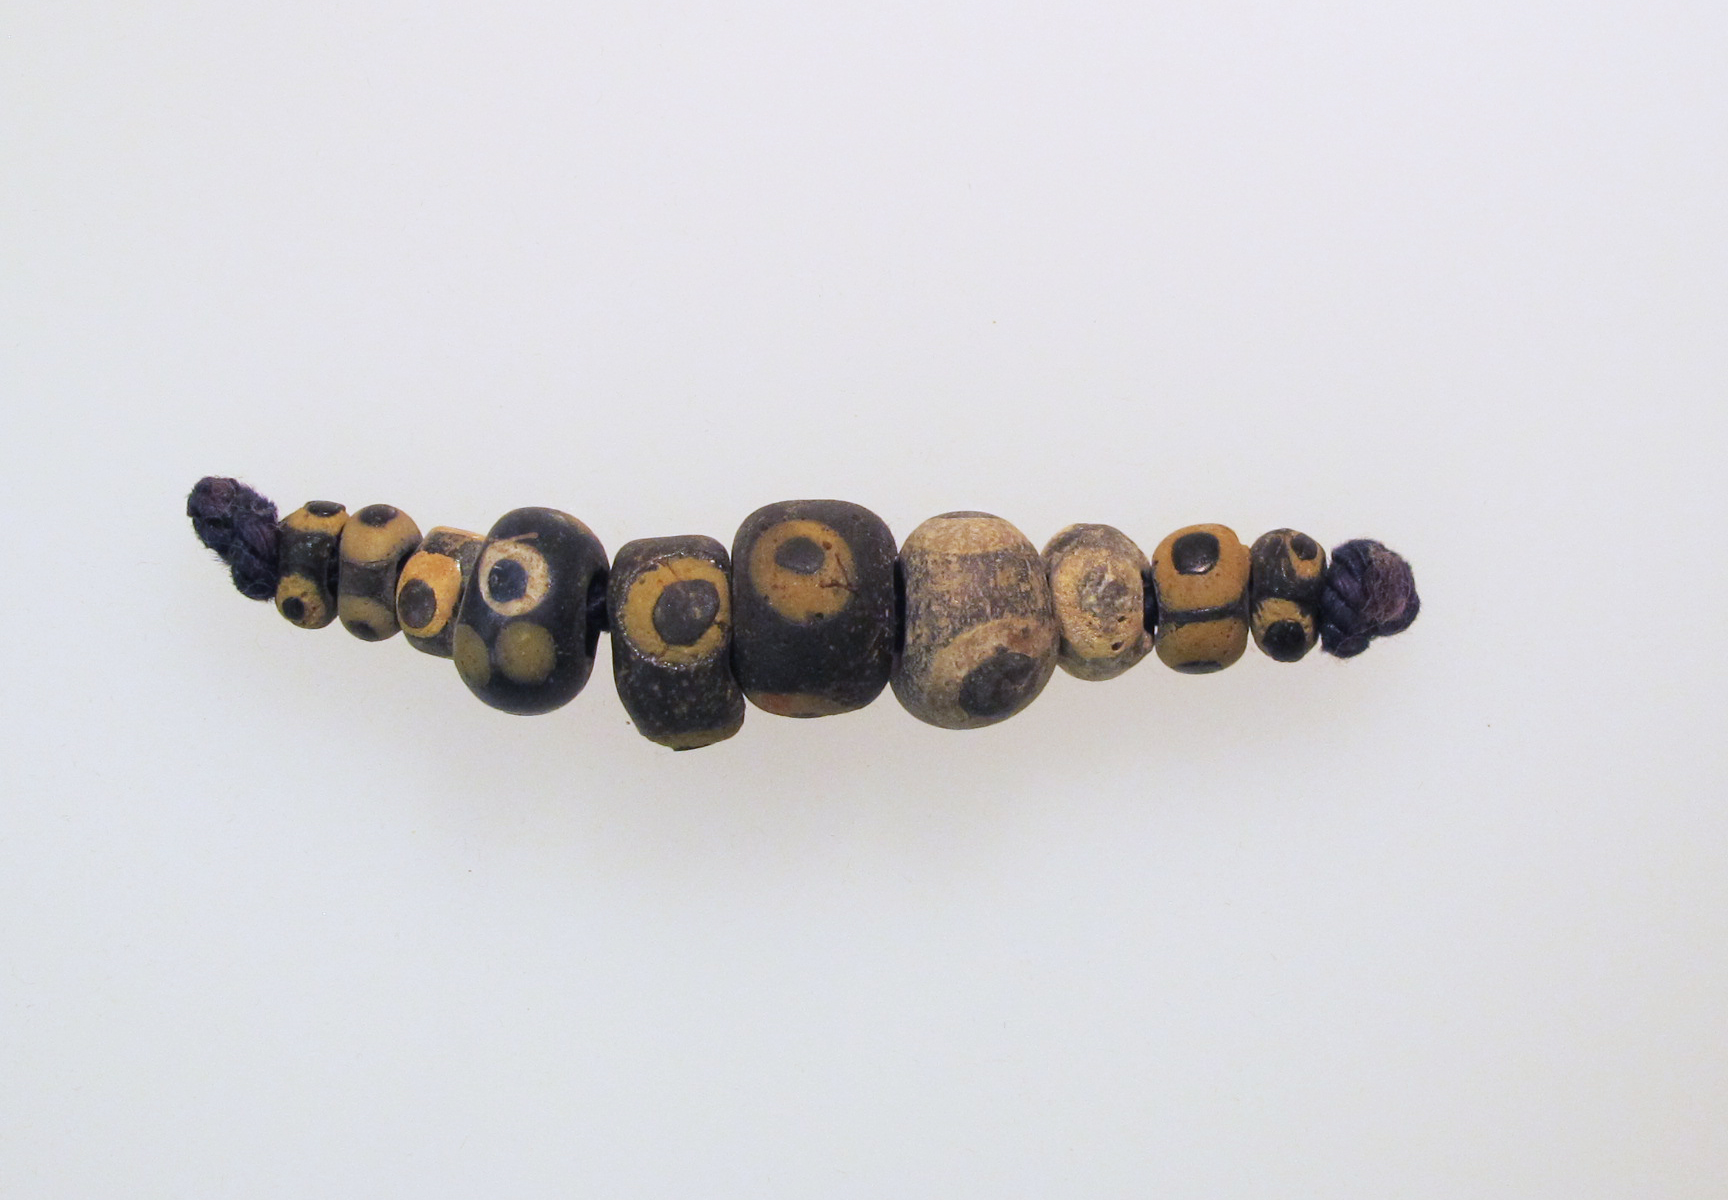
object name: bead, 10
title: Beads, 10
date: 7000 BCE-330 CE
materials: glass